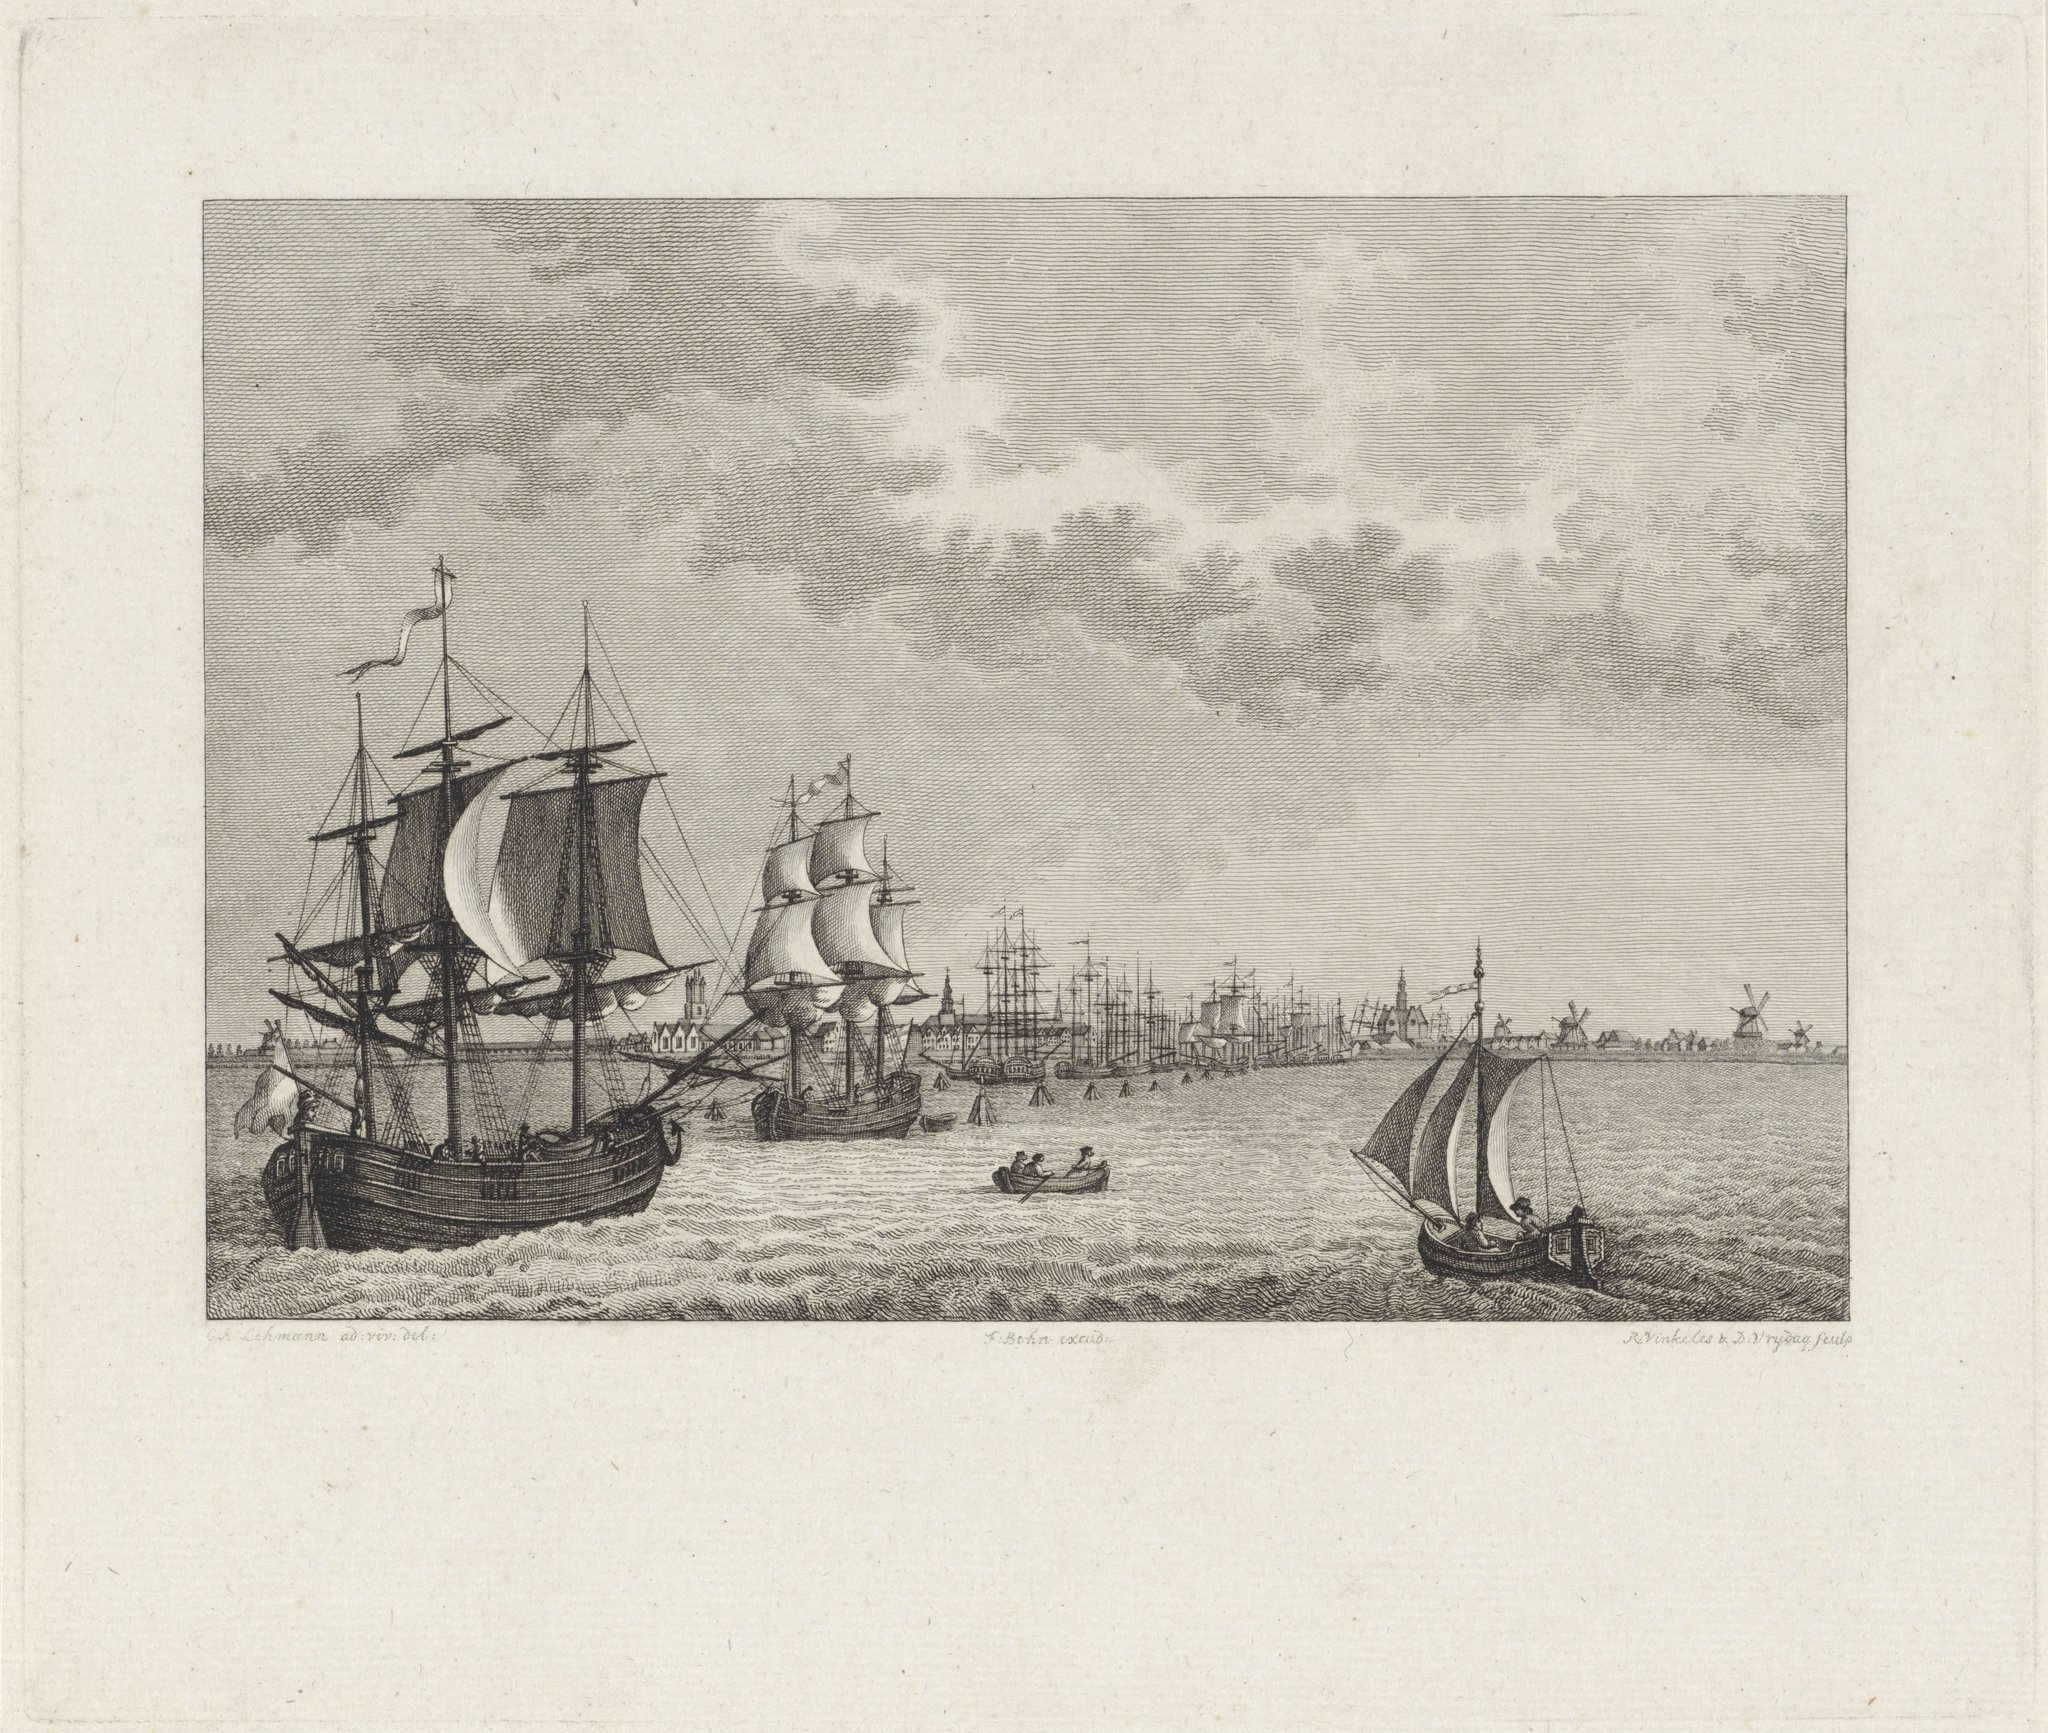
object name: print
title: Gezicht op de haven van Emden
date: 1788-1812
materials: paper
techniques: engraving, etching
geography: haarlem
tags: harbour, sailing-ship, sailing-boat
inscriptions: collector's mark: Lugt 2228